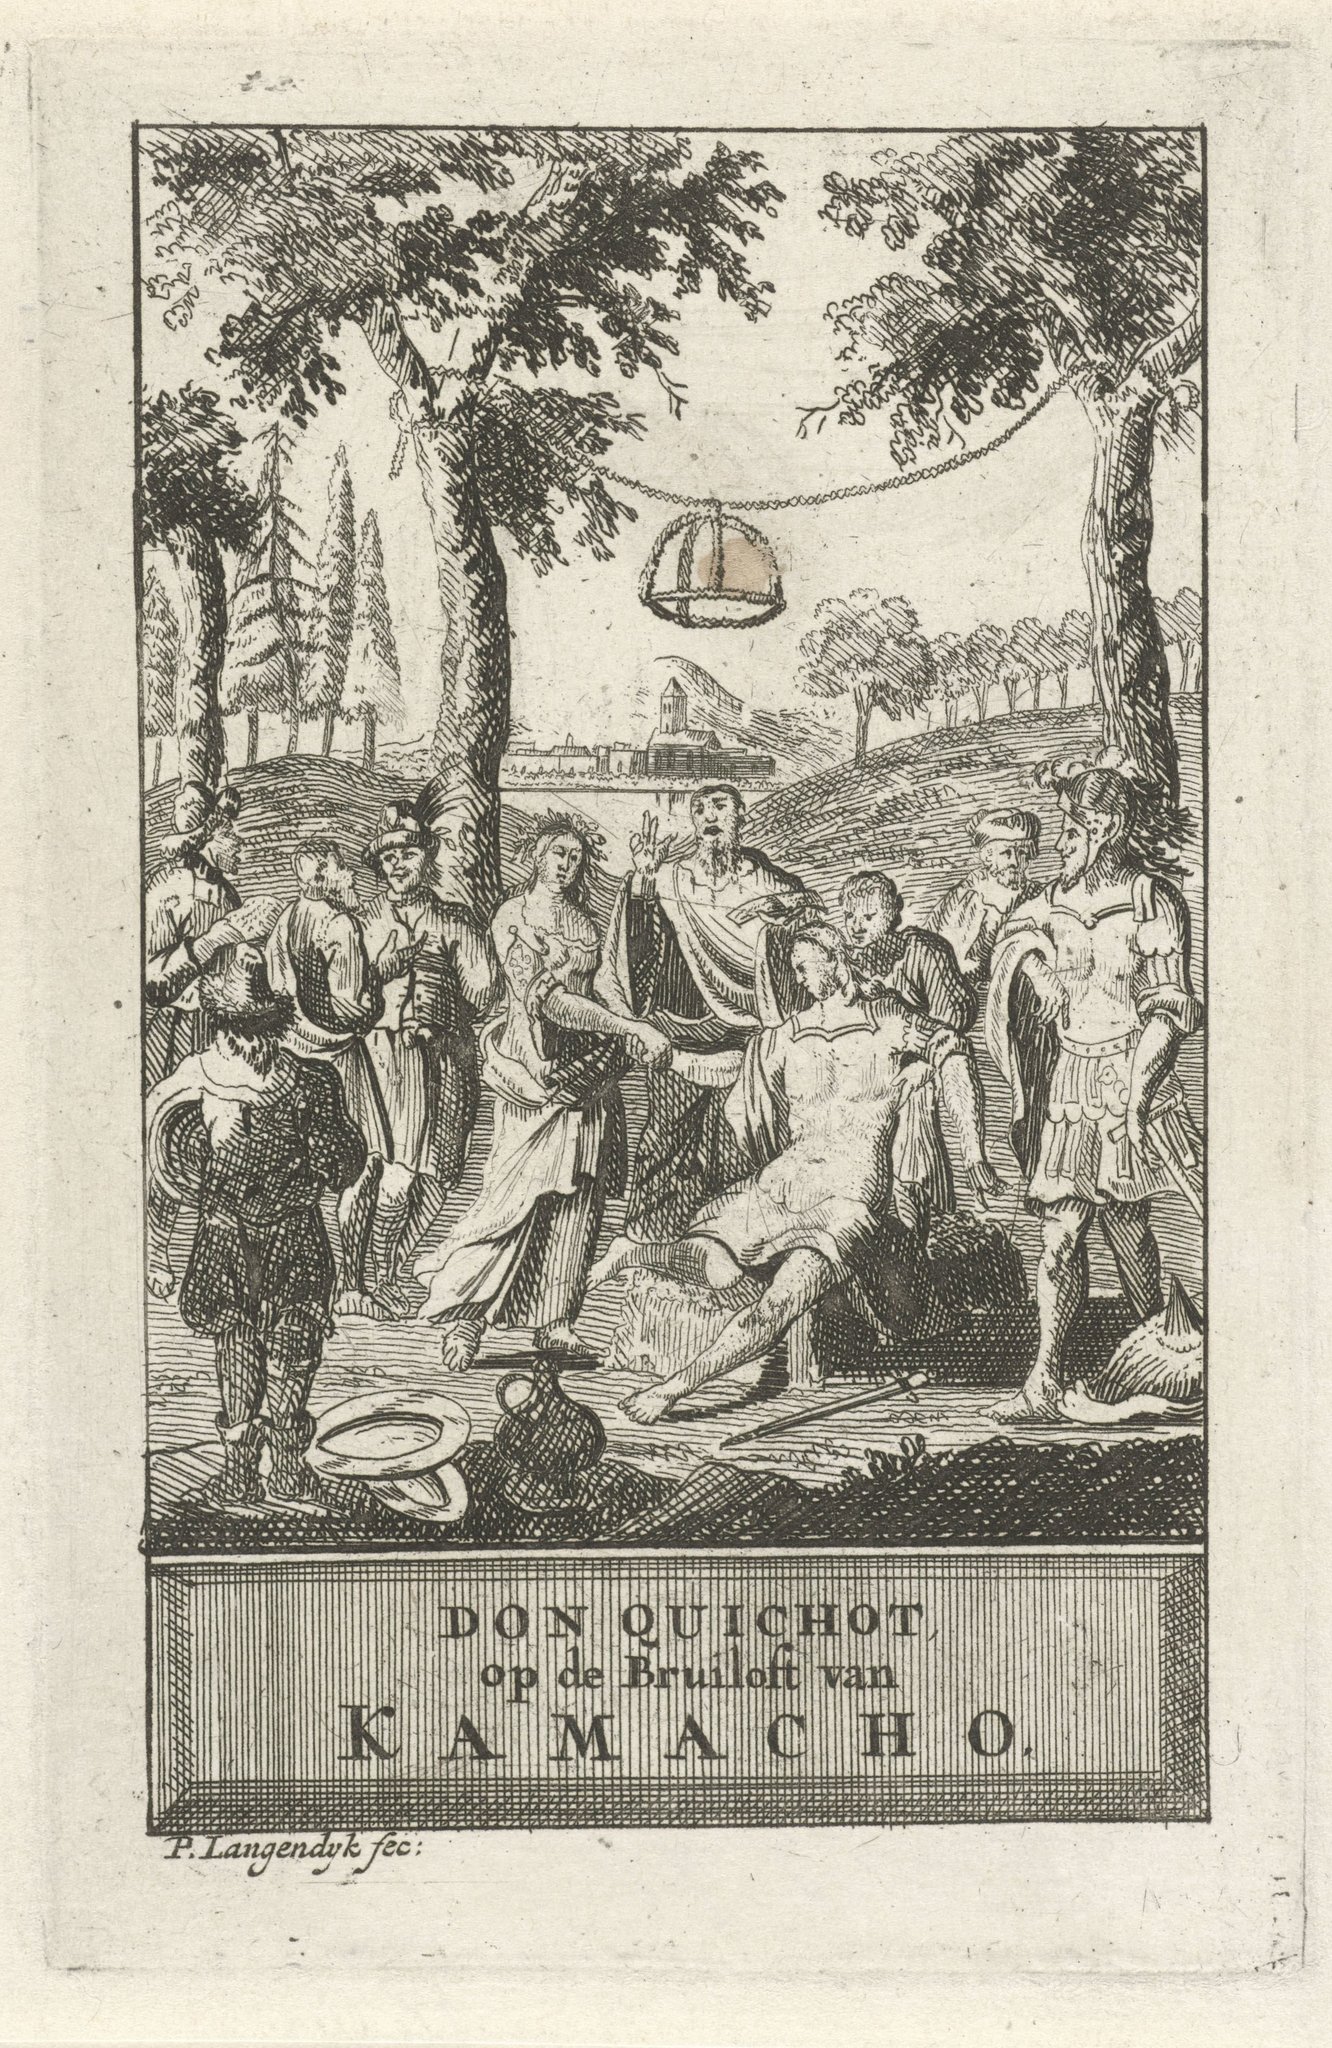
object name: print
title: Titelpagina voor: P. Langendijk, Don Quichot op de bruiloft van Kamacho, 1712-1714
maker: pieter langendijk (i)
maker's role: print maker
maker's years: 1683-1756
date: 1712-1714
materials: paper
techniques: etching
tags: civil marriage ceremony, blessing the married couple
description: Omringd door omstanders geeft Quiteria haar bruidegom Bazilius de hand. Eigenlijk zou het verhaal gaan om de bruiloft van Quiteria en Kamacho maar dat werd die van Bazilius en Quiteria. Bazilius is gewond, naast hem op de grond ligt het zwaard waarmee hij zich uit liefdesverdriet vlak voor de bruiloft heeft gestoken. Zijn laatste wens was om voor zijn sterven in plaats van Kamacho met Quiteria te trouwen. Achter het bruidspaar staat een priester die het huwelijk inzegent. Na de inzegening staat Bazilius gezond en wel weer op. Uiterst rechts kijkt Don Quichot in harnas toe.